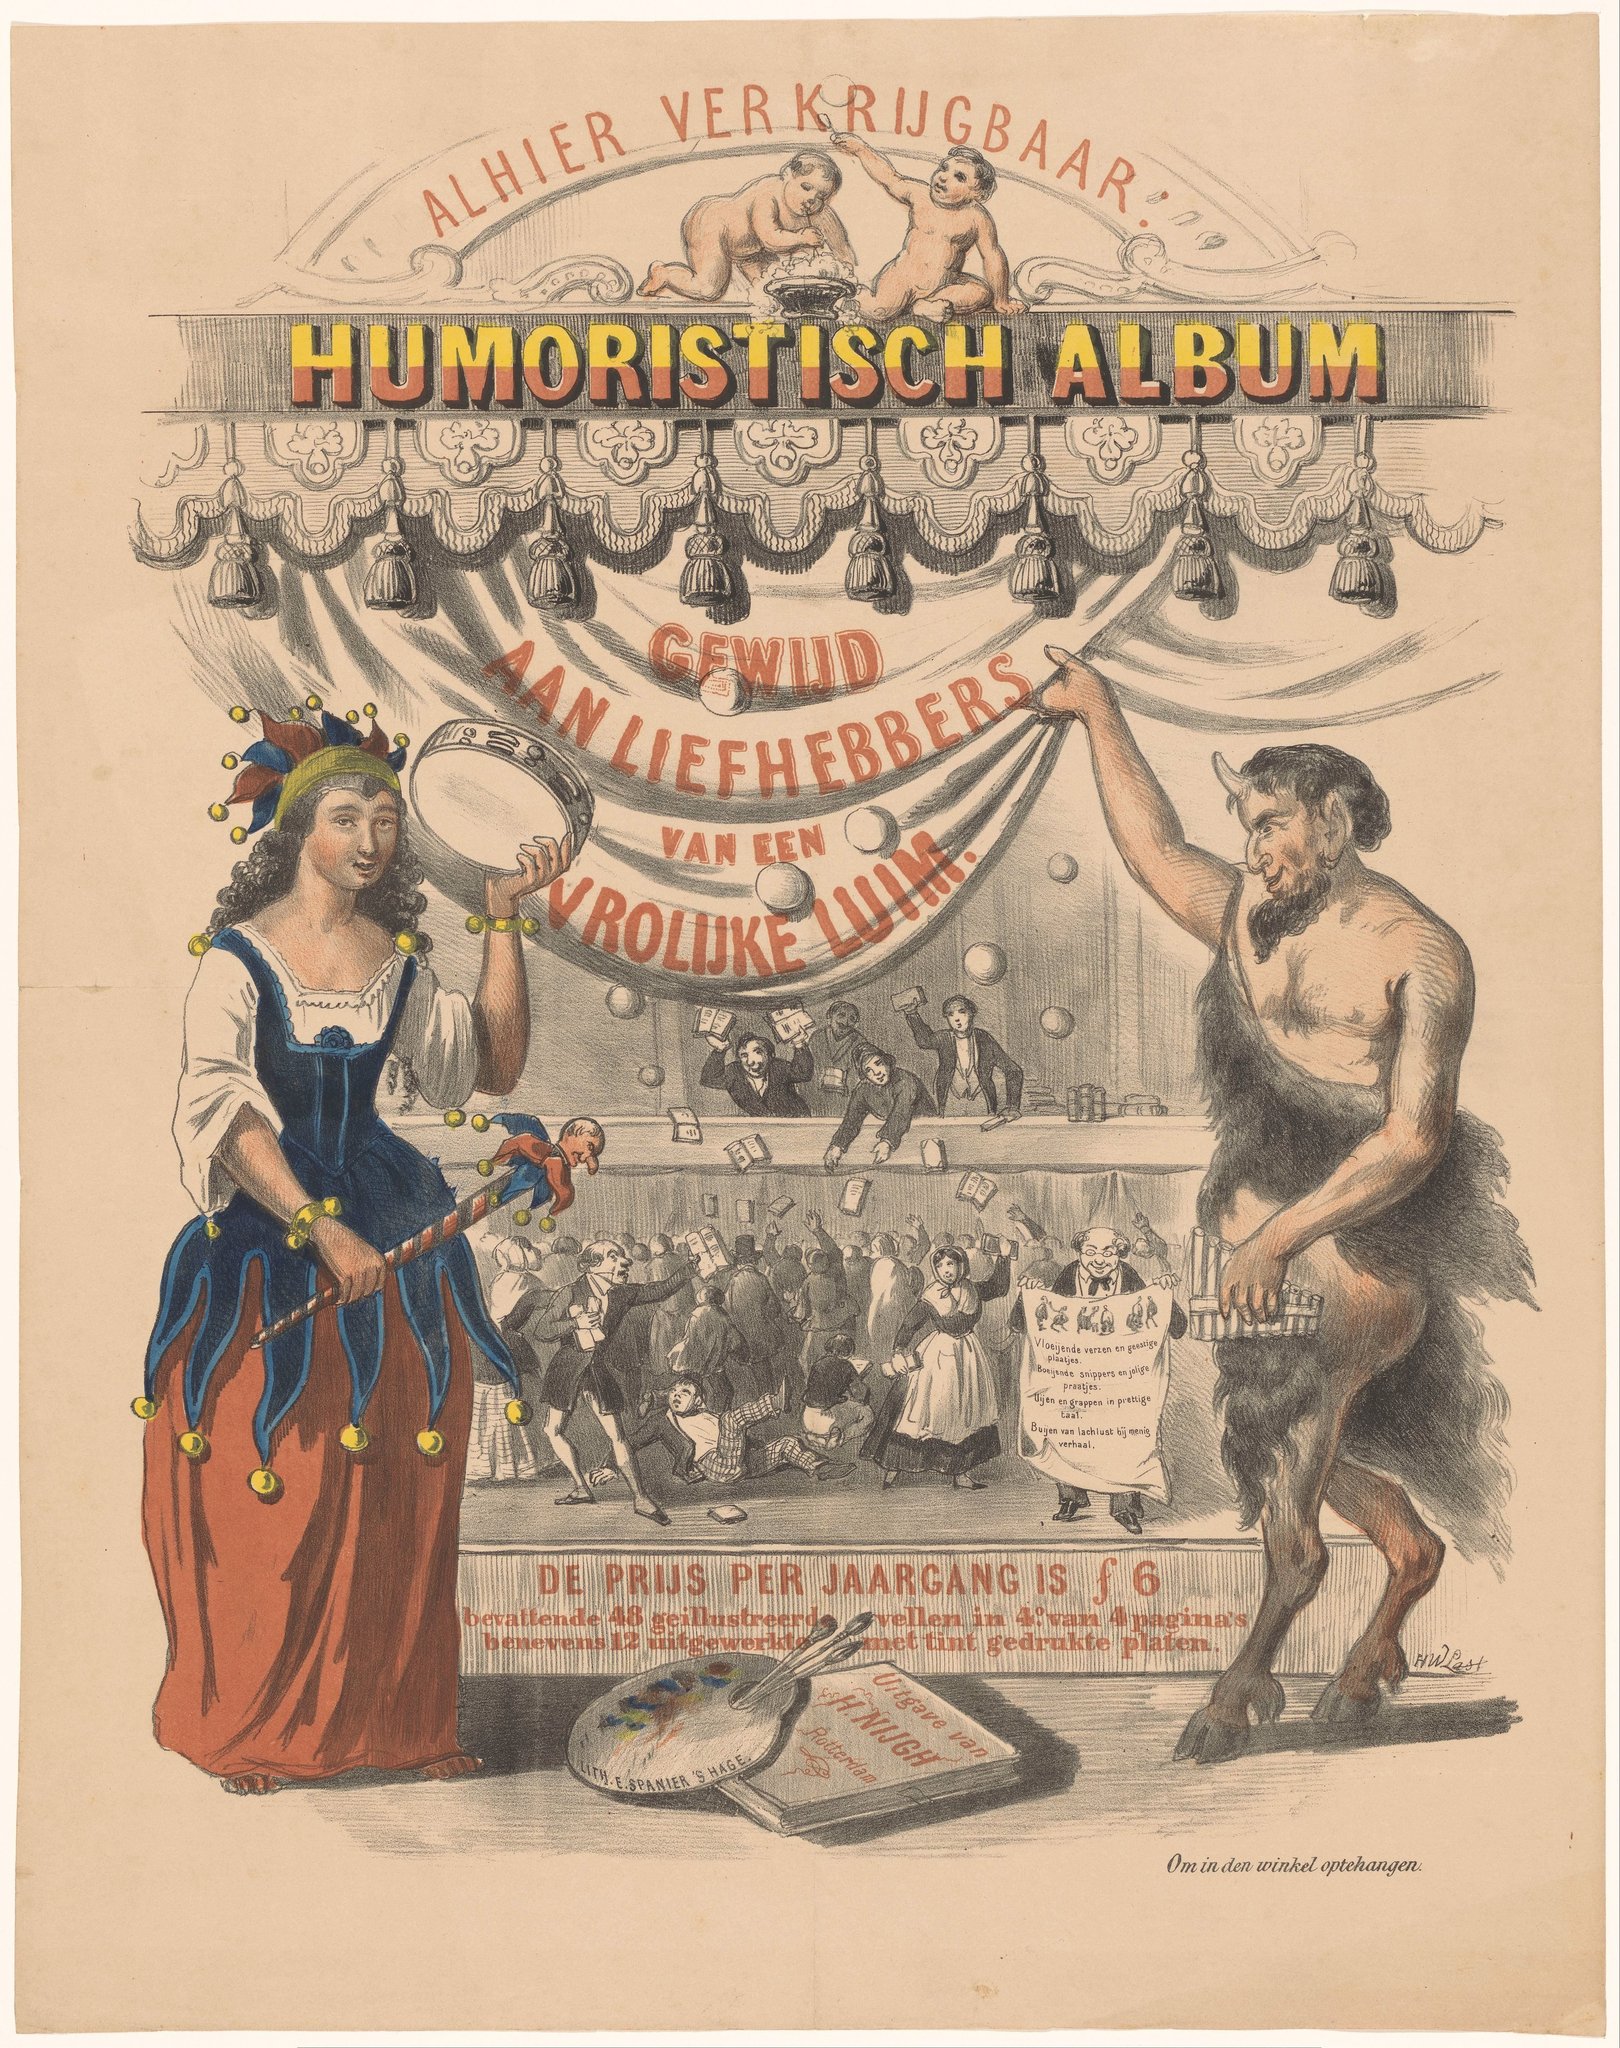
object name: print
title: Affiche voor het weekblad Humoristisch Album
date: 1855-1863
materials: paper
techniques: hand coloring, lithograph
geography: rotterdam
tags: court jester, court fool, tambourine, satyr(s) (in general), palette, (children or putti) blowing bubbles, 'homo bulla' ~ scene symbolizing 'vanitas'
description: Links een vrouw in narrenkostuum met een tamboerijn en een narrenstok in haar handen. Rechts houdt een sater met een panfluit een gordijn omhoog. In het midden gooien vier mannen boeken van een balustrade die daaronder door een menigte worden opgevangen. Boven twee putti die bellen blazen; onder een schilderspalet en een boek met het adres van de uitgever.